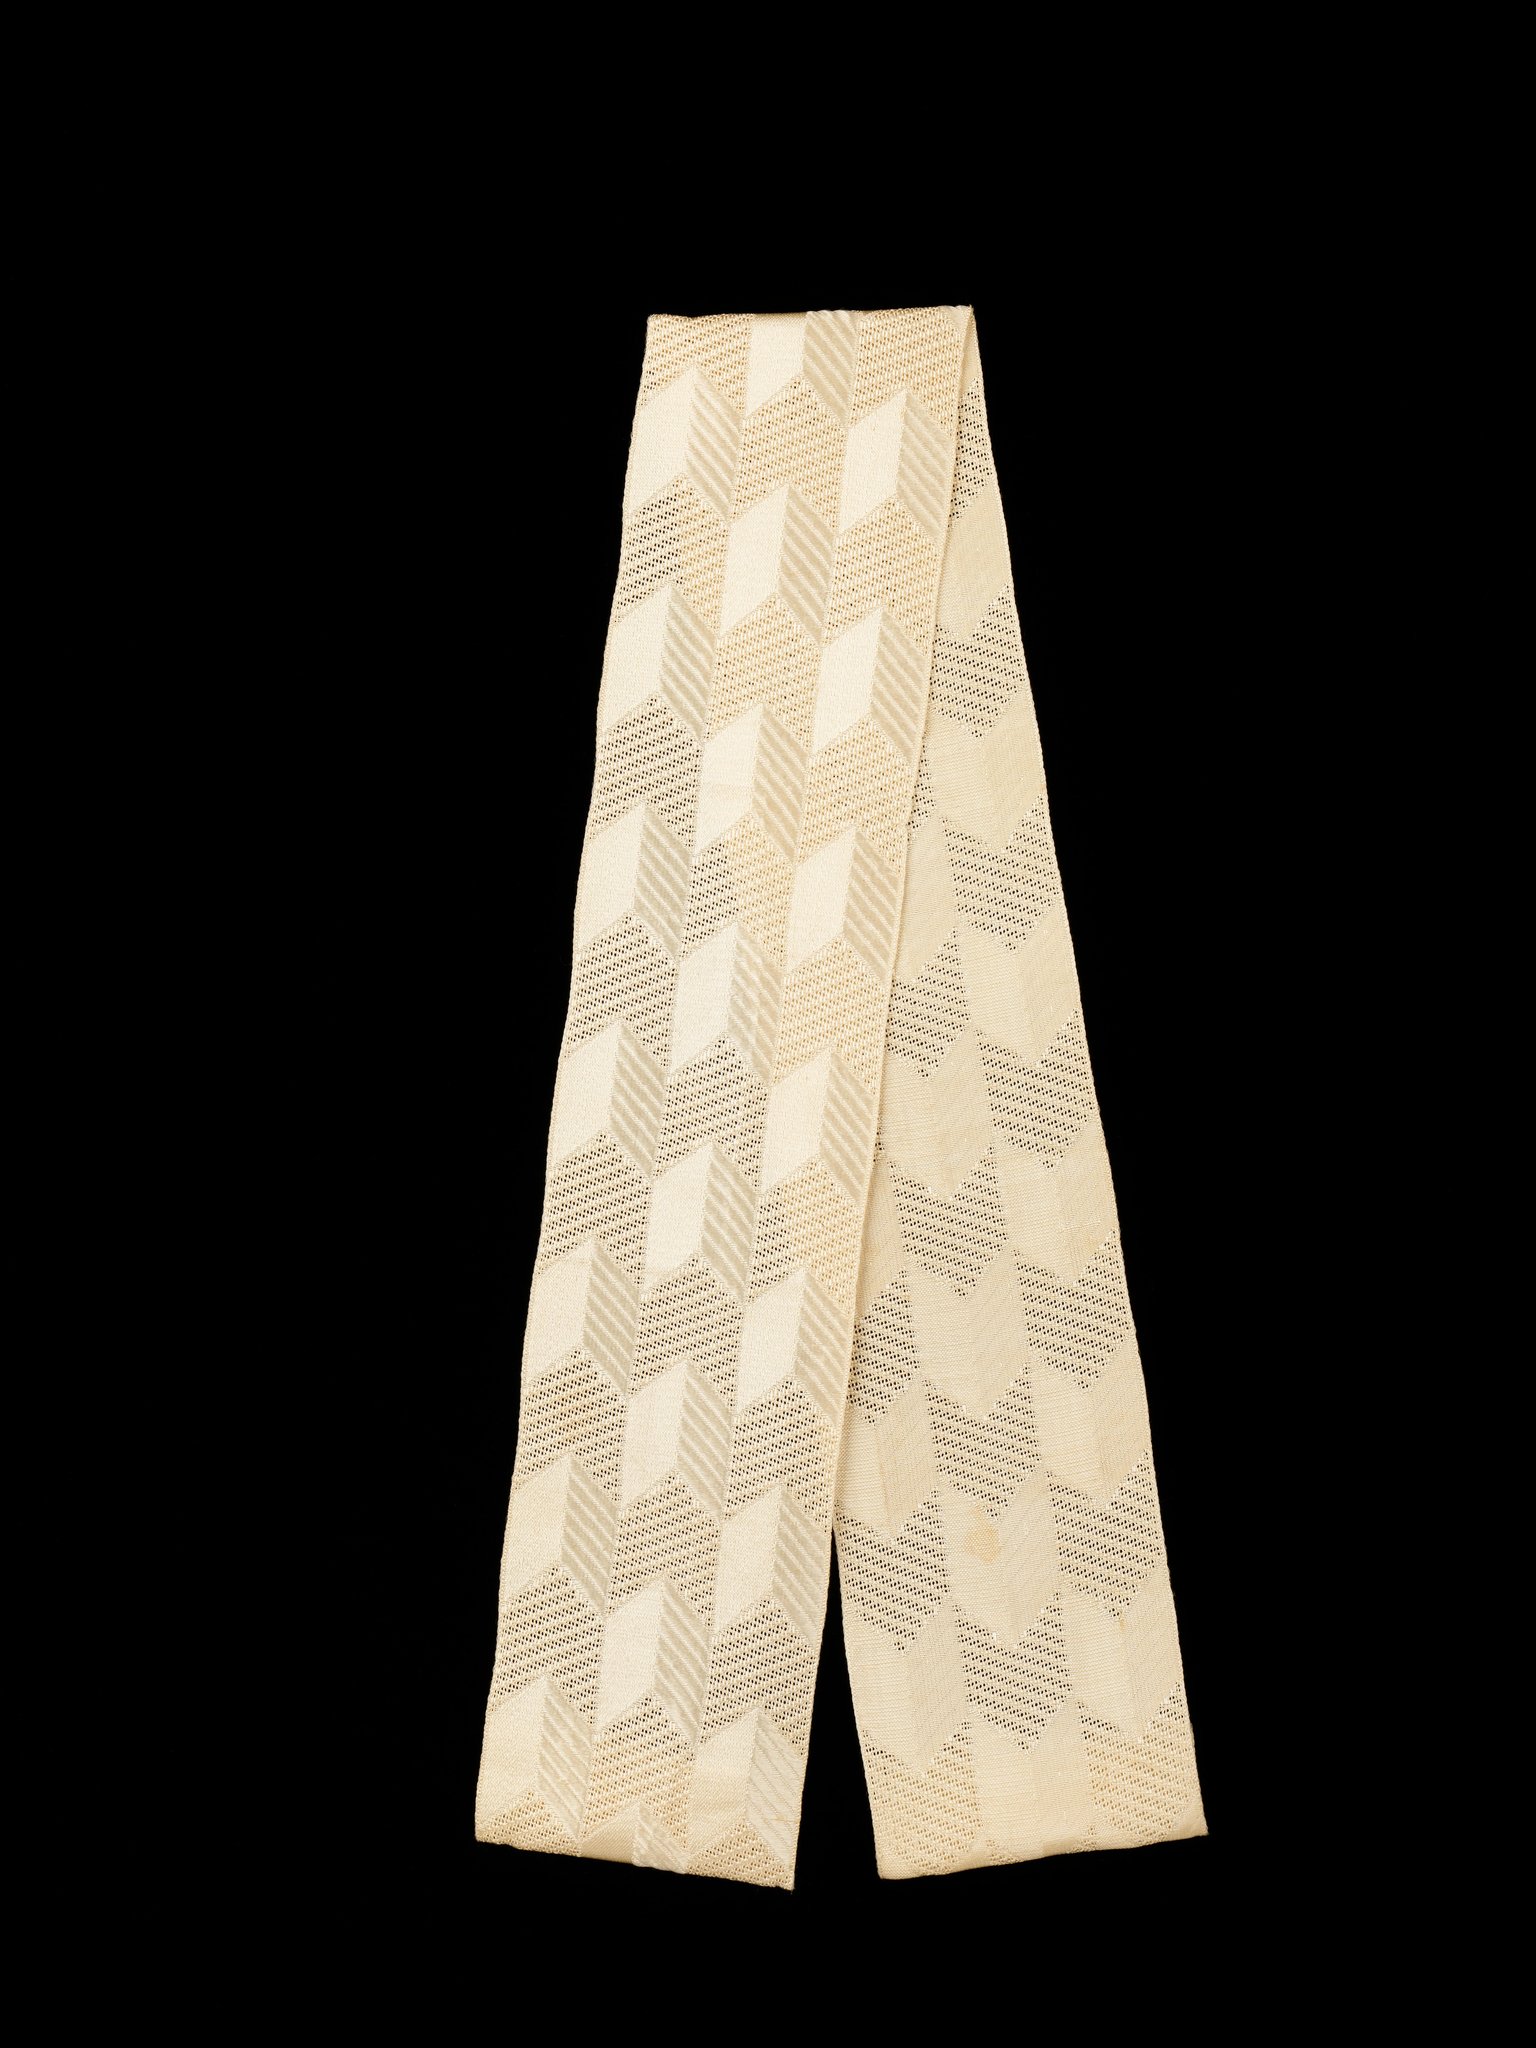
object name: ribbon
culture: french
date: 1870-1889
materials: silk